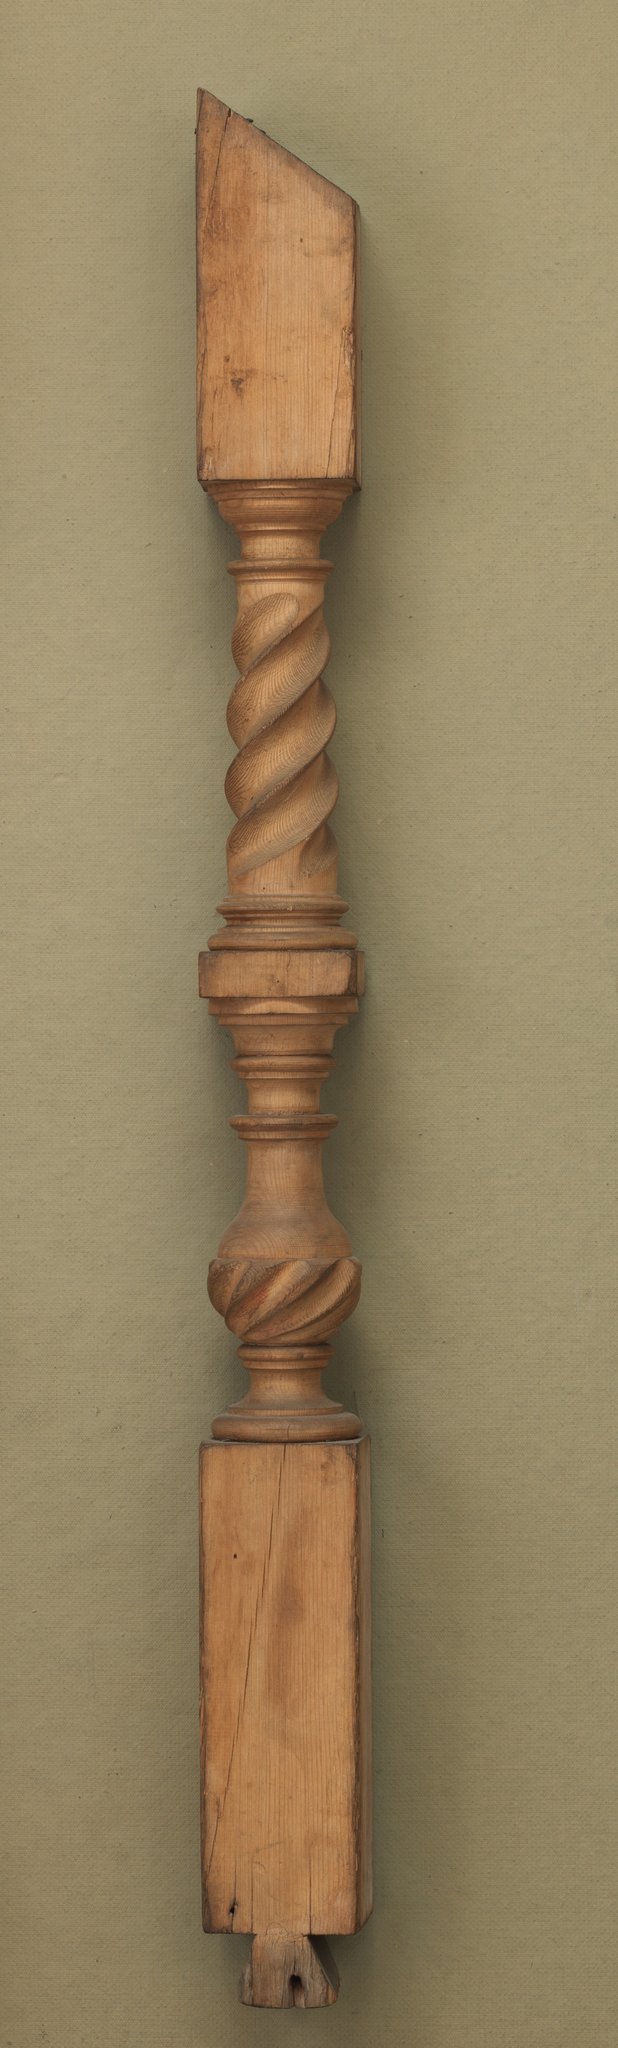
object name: baluster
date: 1734-1766